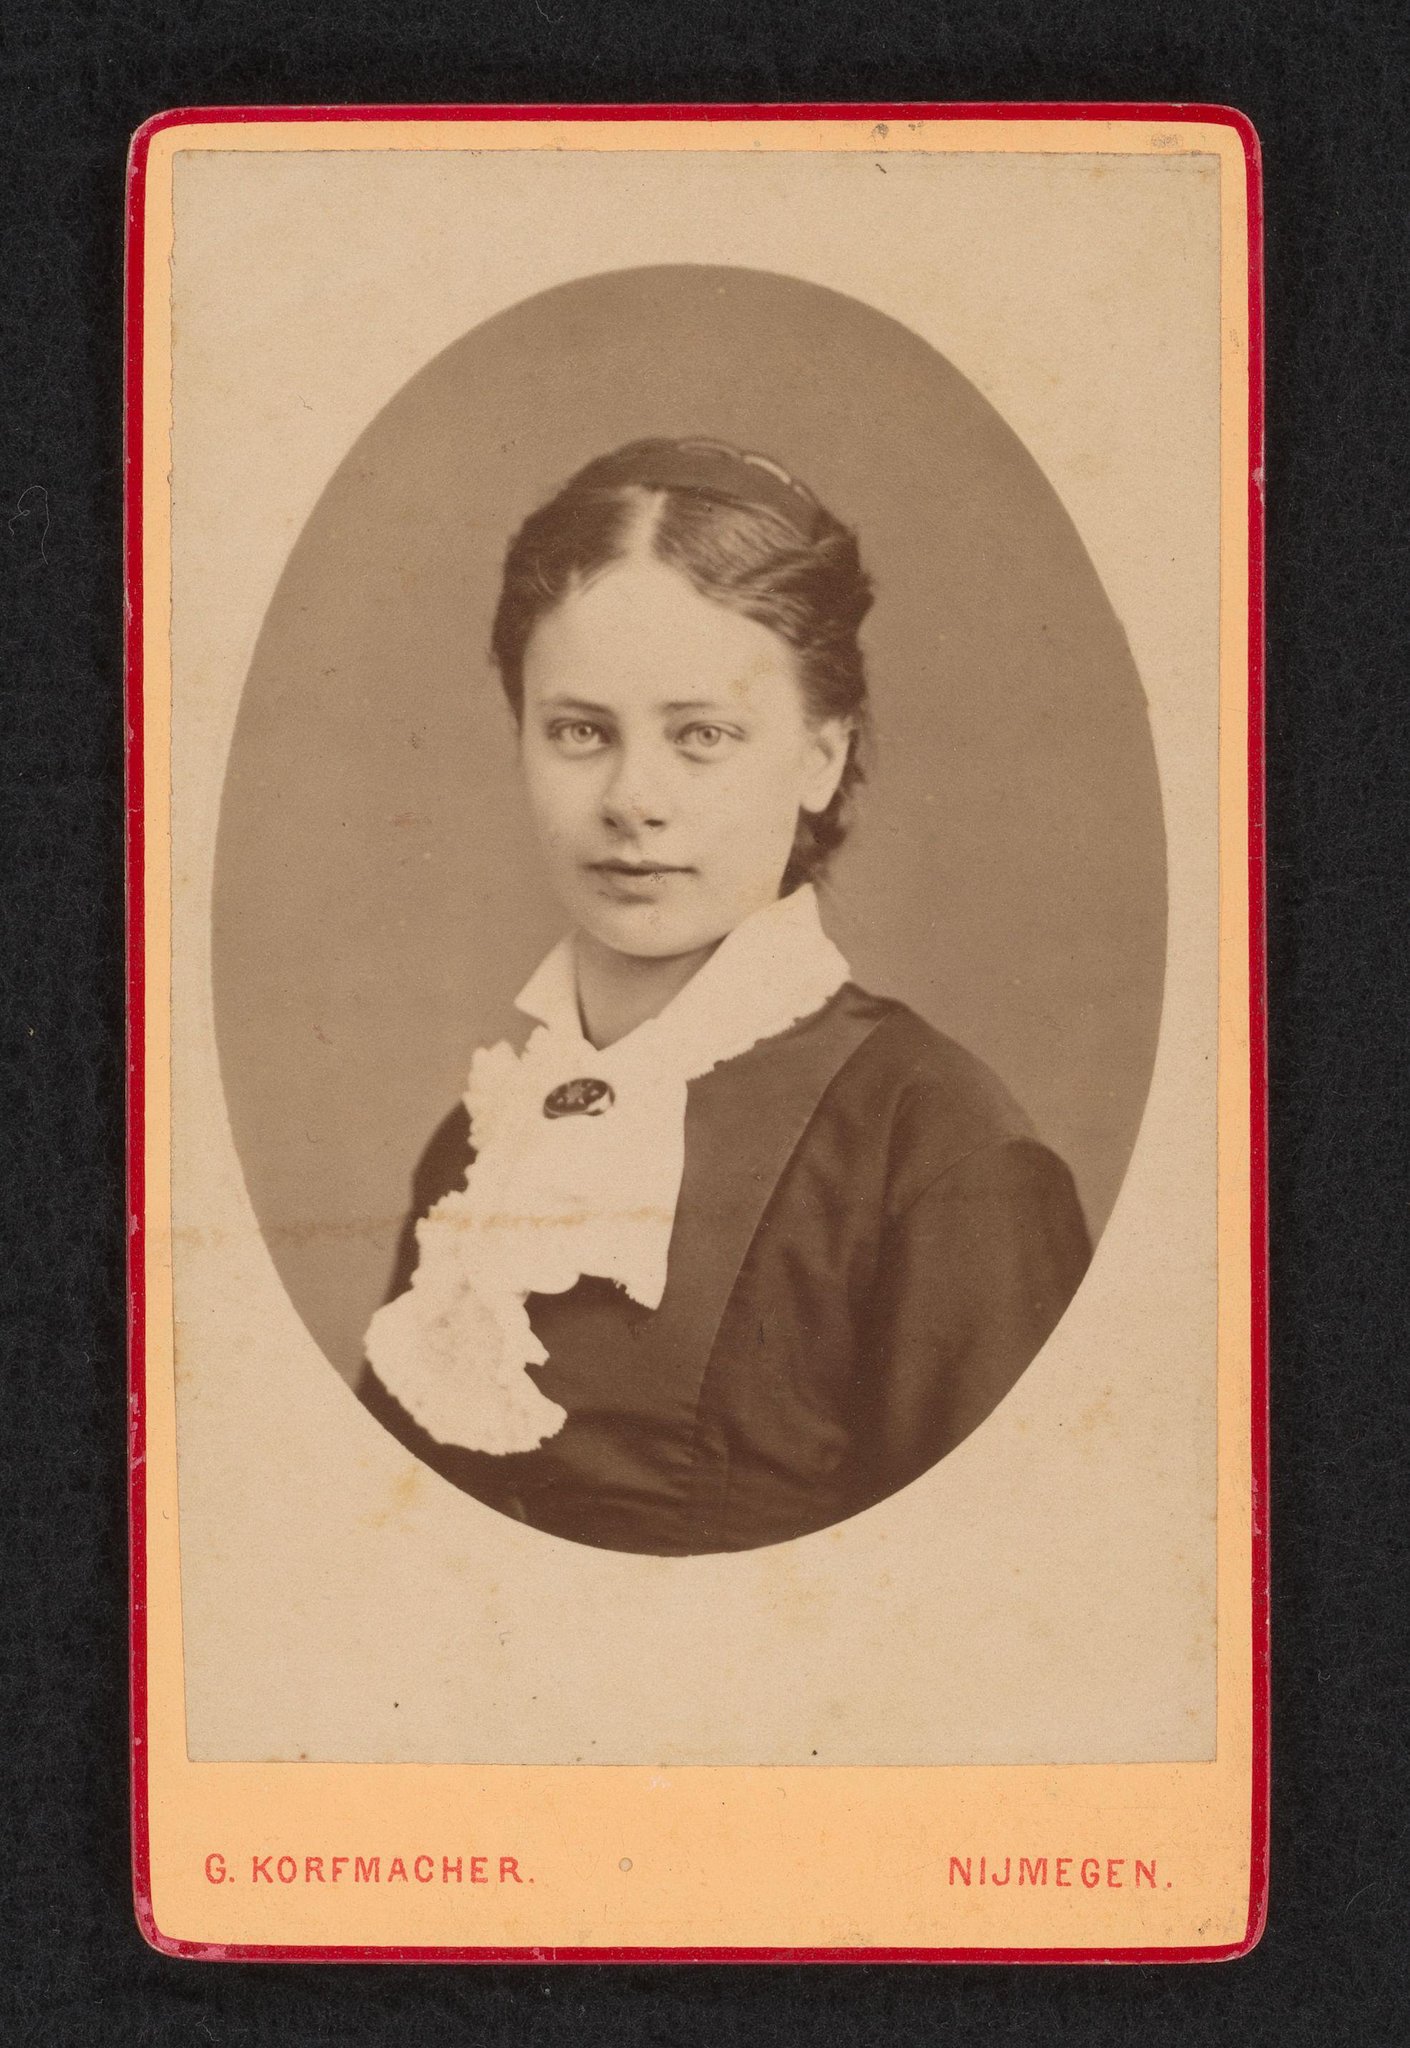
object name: semi enamel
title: Portret van een vrouw met witte kraag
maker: gerard karel martin hubert korfmacher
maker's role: fotograaf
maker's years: 1835-1914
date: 1880-1900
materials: cardboard, photographic support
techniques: albumen print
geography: nijmegen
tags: historical persons - bb - woman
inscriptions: inscription: ‘Photographie van G. Korfmacher te Nijmegen/ Hoek Molenstraat B. 678 (...)’